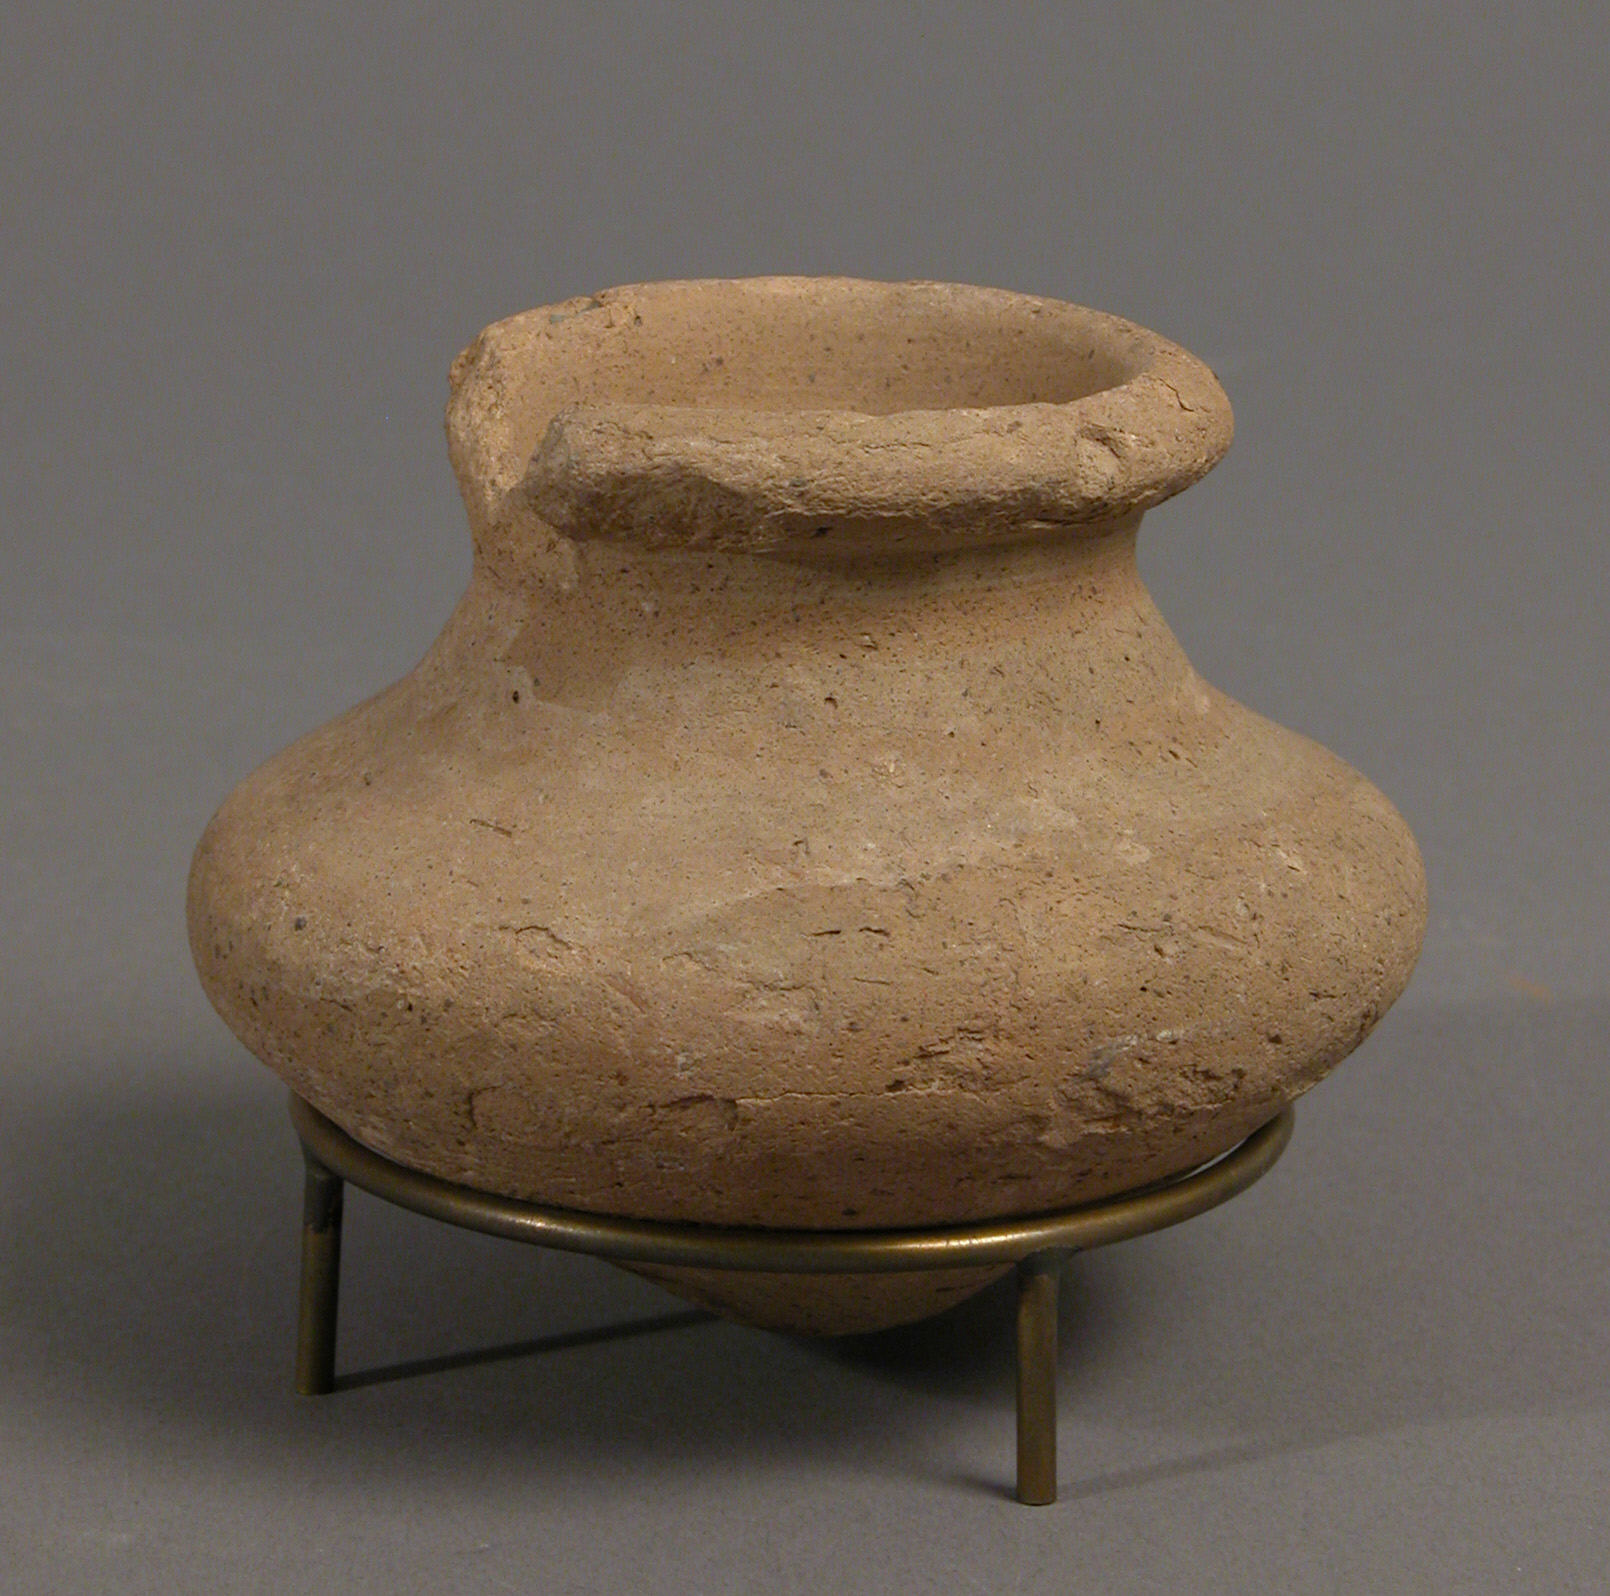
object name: pot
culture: coptic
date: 301-700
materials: earthenware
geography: egypt